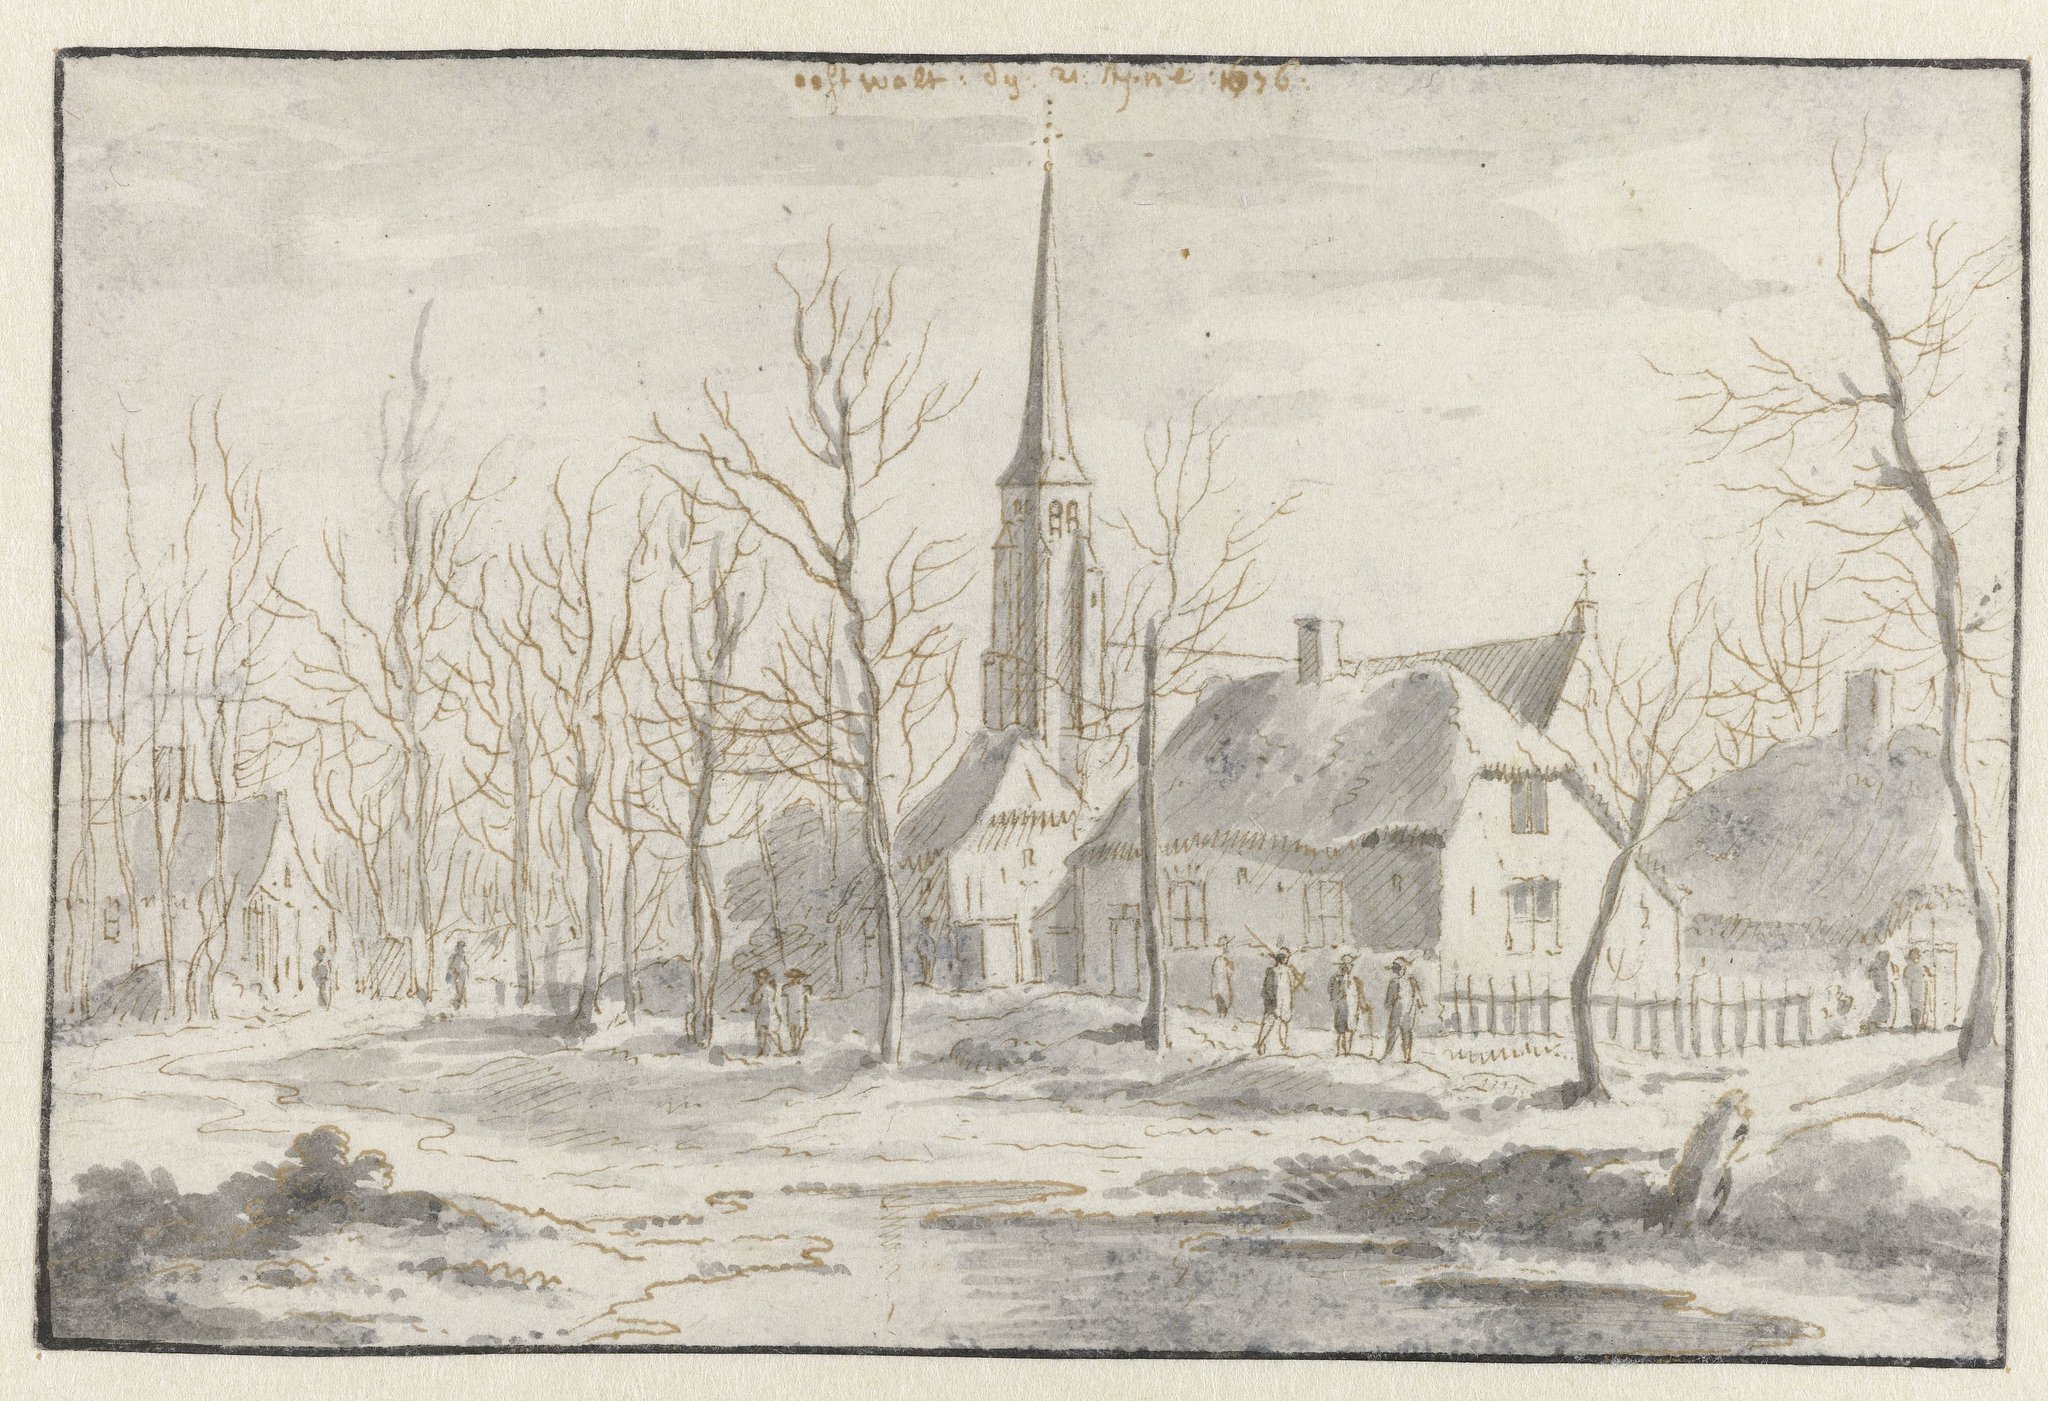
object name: drawing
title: View of Oostwold, Groningen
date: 1676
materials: ink, paper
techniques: brush, pen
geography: oostwold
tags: prospect of village, silhouette of village, church (exterior), oostwold